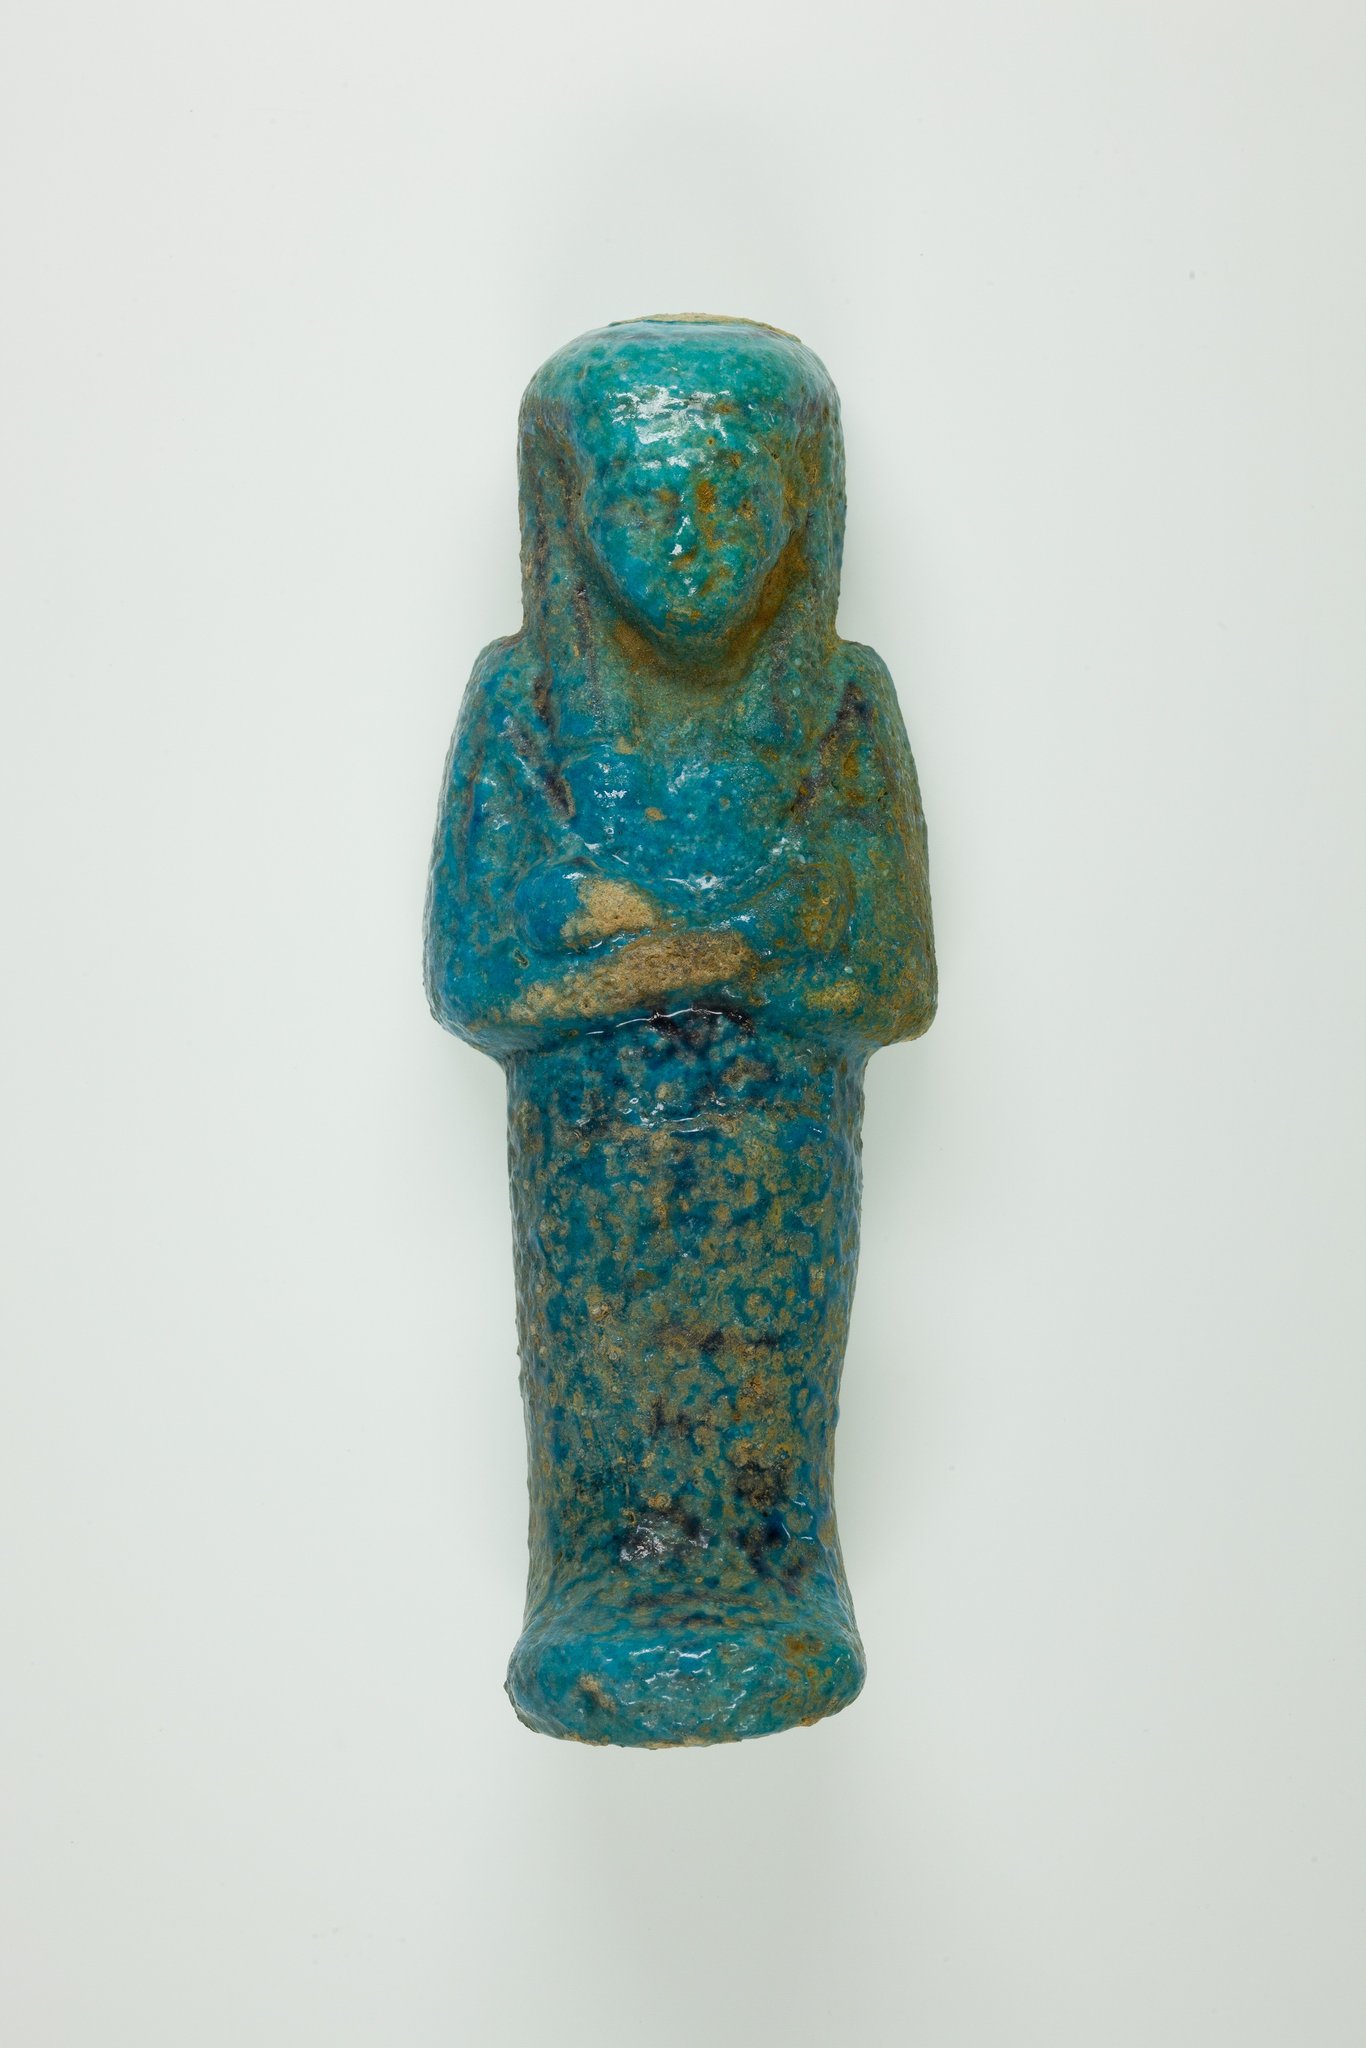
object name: worker shabti, henettawy c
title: Worker Shabti of Henettawy (C), Daughter of Isetemkheb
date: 990-970 BCE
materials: faience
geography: egypt